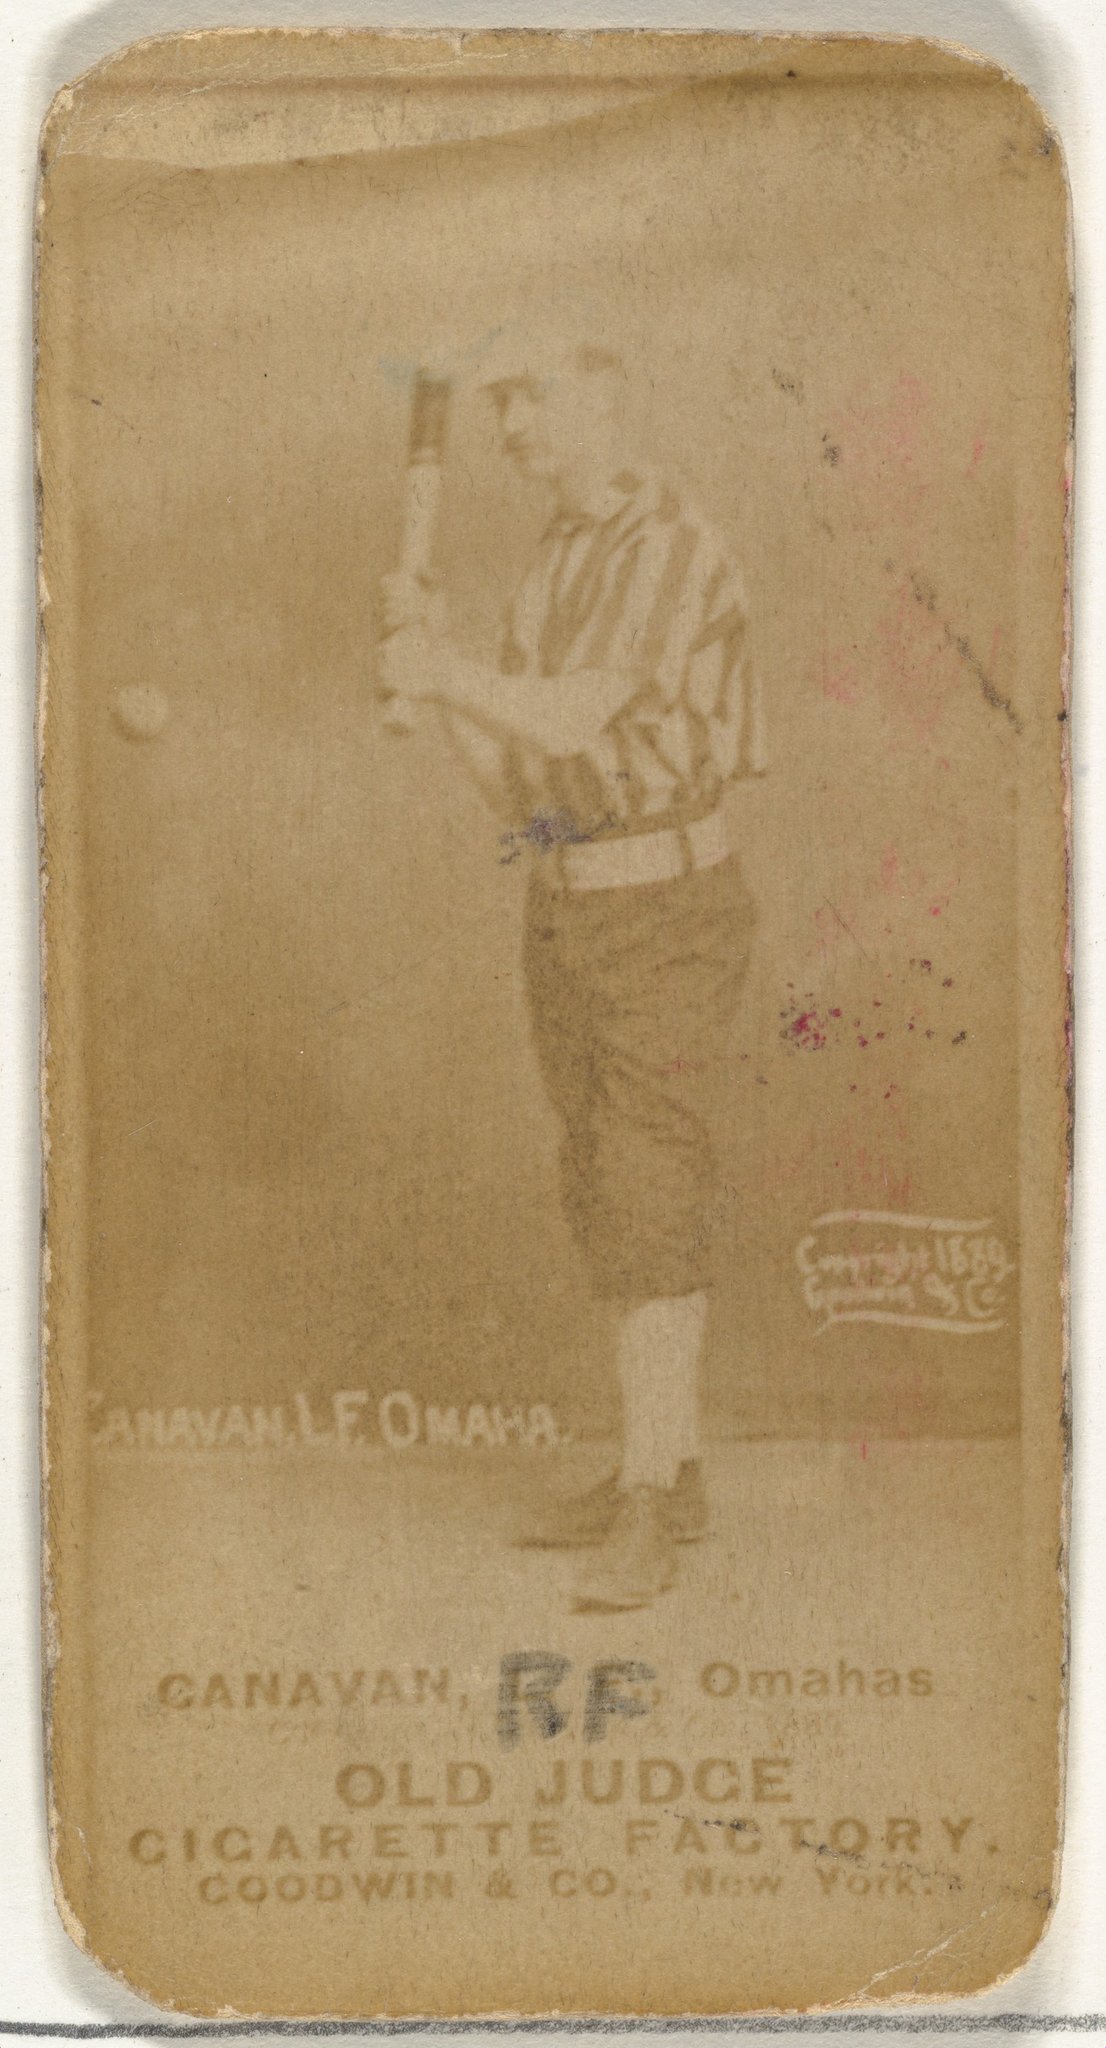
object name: baseball card, photograph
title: James Edward "Jim" Canavan, Left Field, Omaha Omahogs/ Lambs, from the Old Judge series (N172) for Old Judge Cigarettes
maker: goodwin & company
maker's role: publisher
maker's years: 1850-1950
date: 1889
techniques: albumen silver print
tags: men,portraits,baseball,athletes